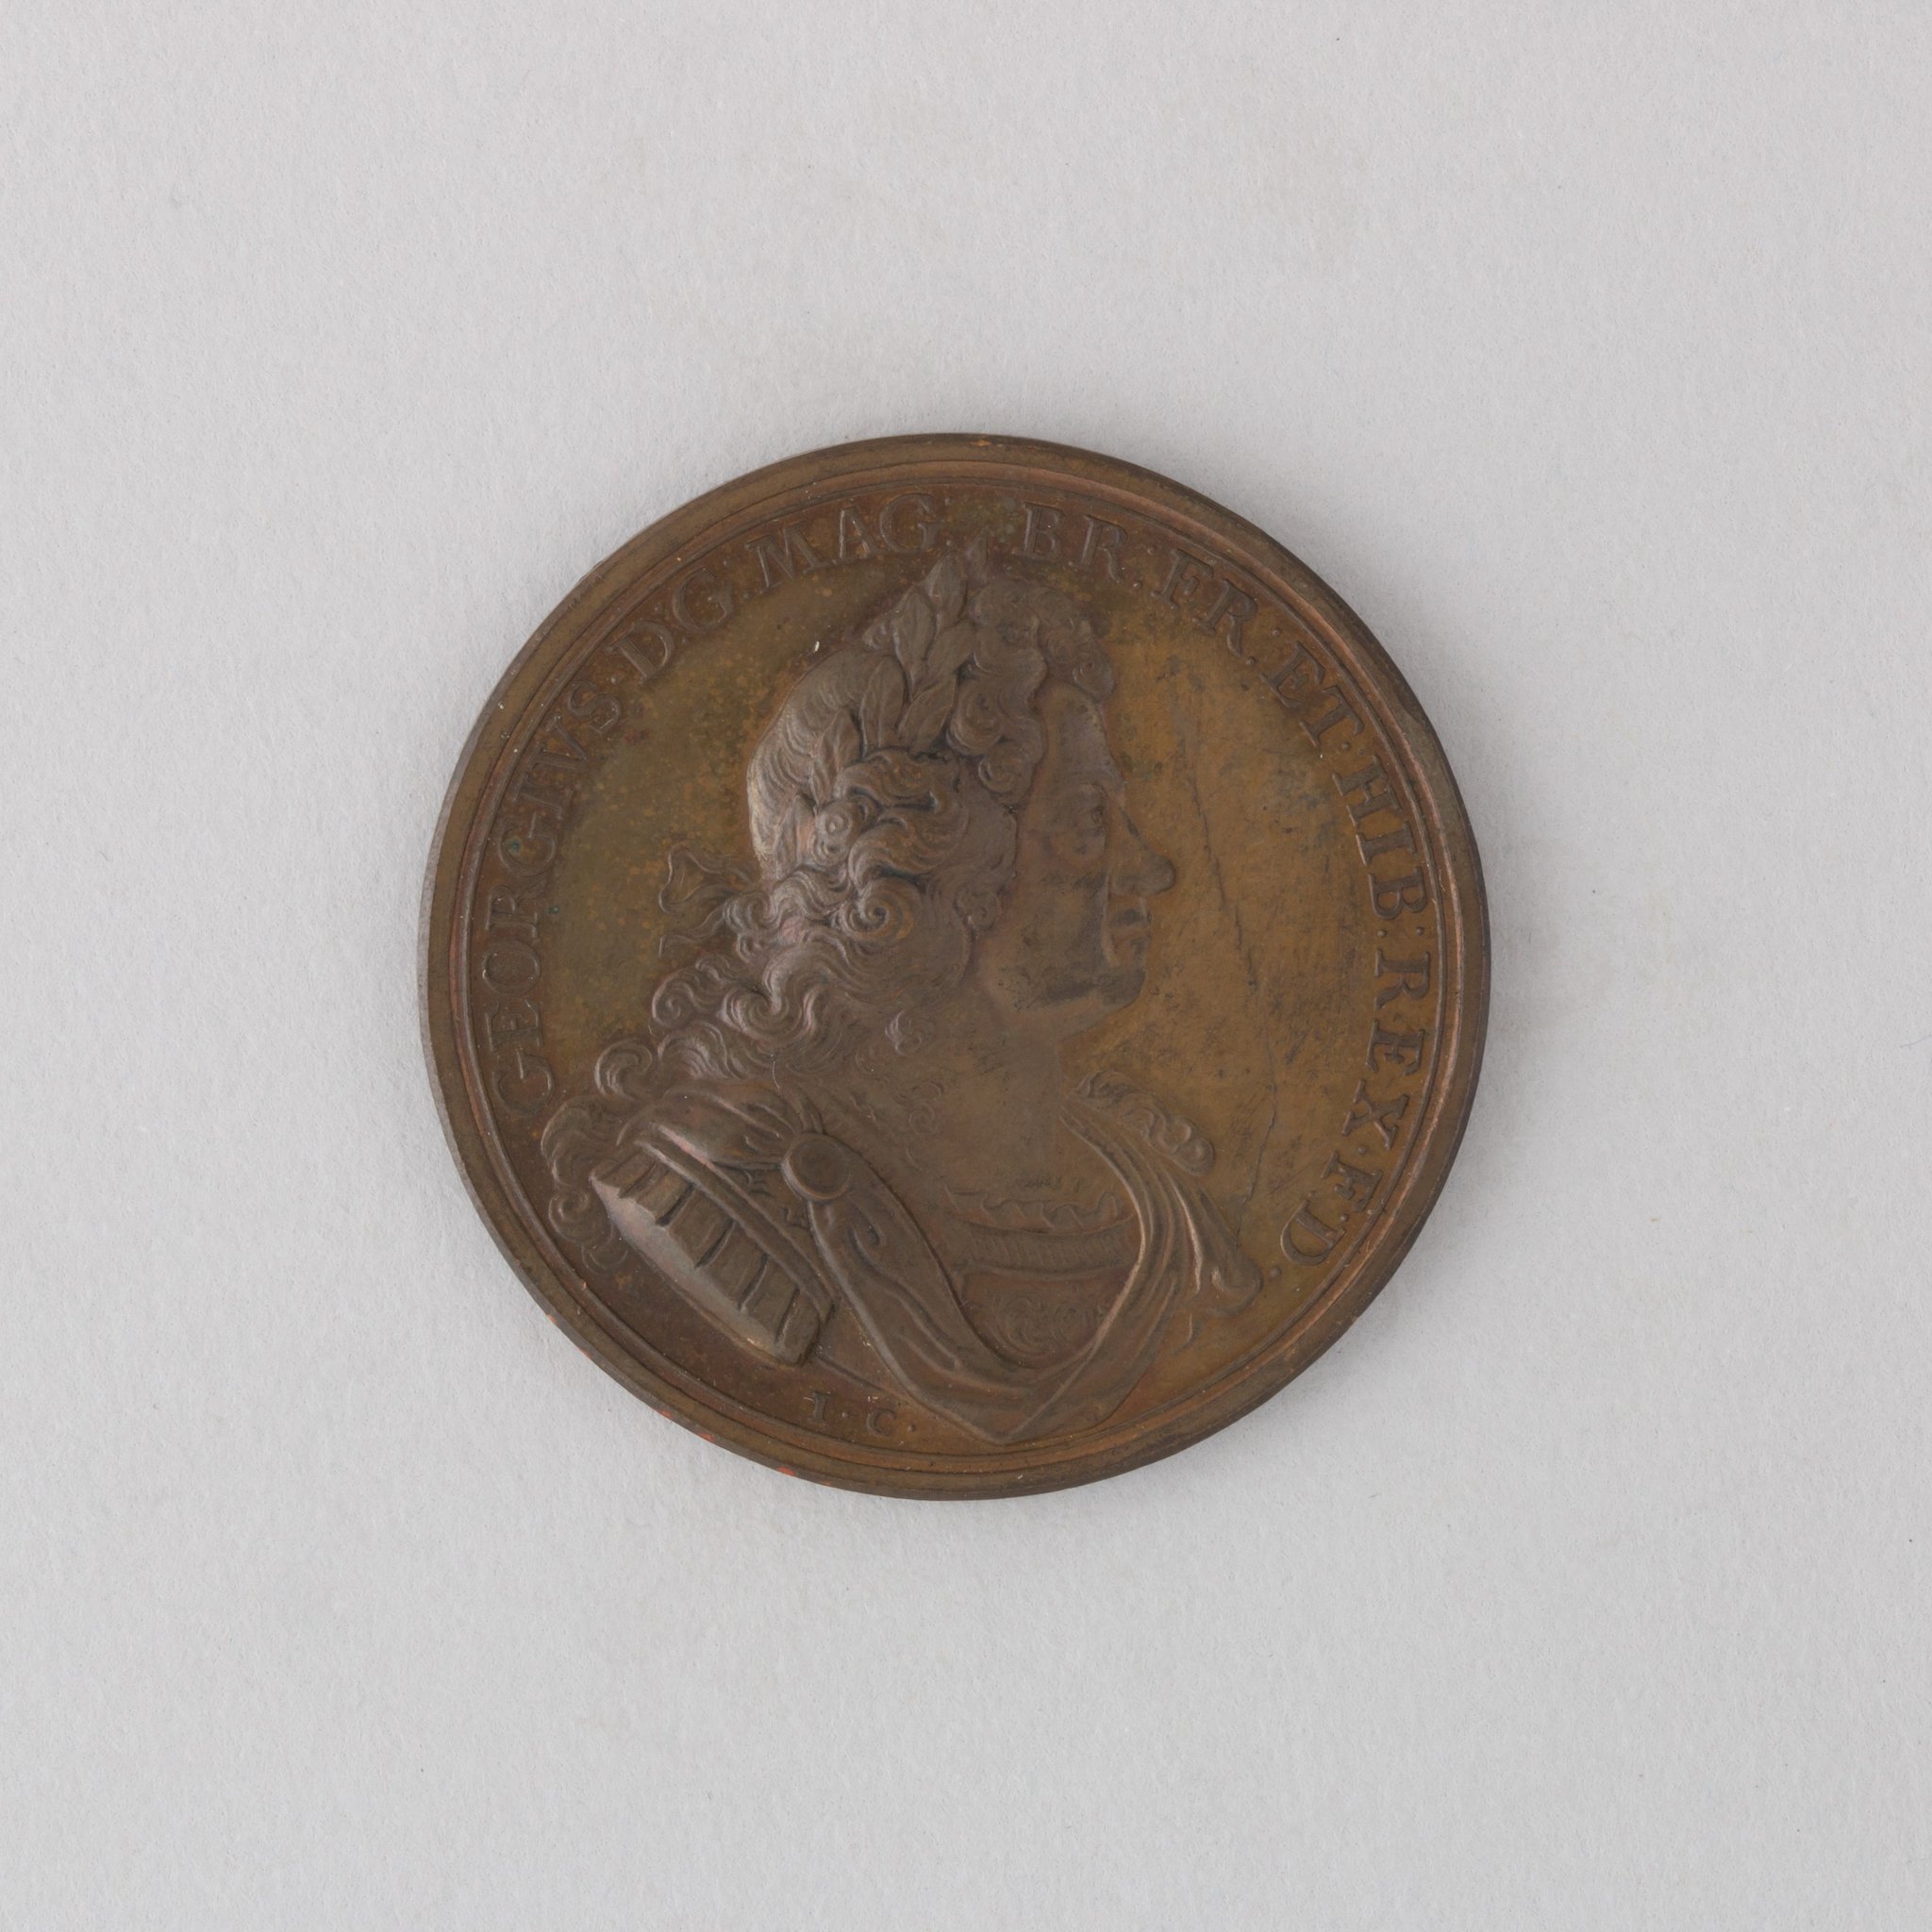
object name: medal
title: Medal Commemorating Preston Taken, Showing George I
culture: british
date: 1715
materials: bronze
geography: england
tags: men,profiles